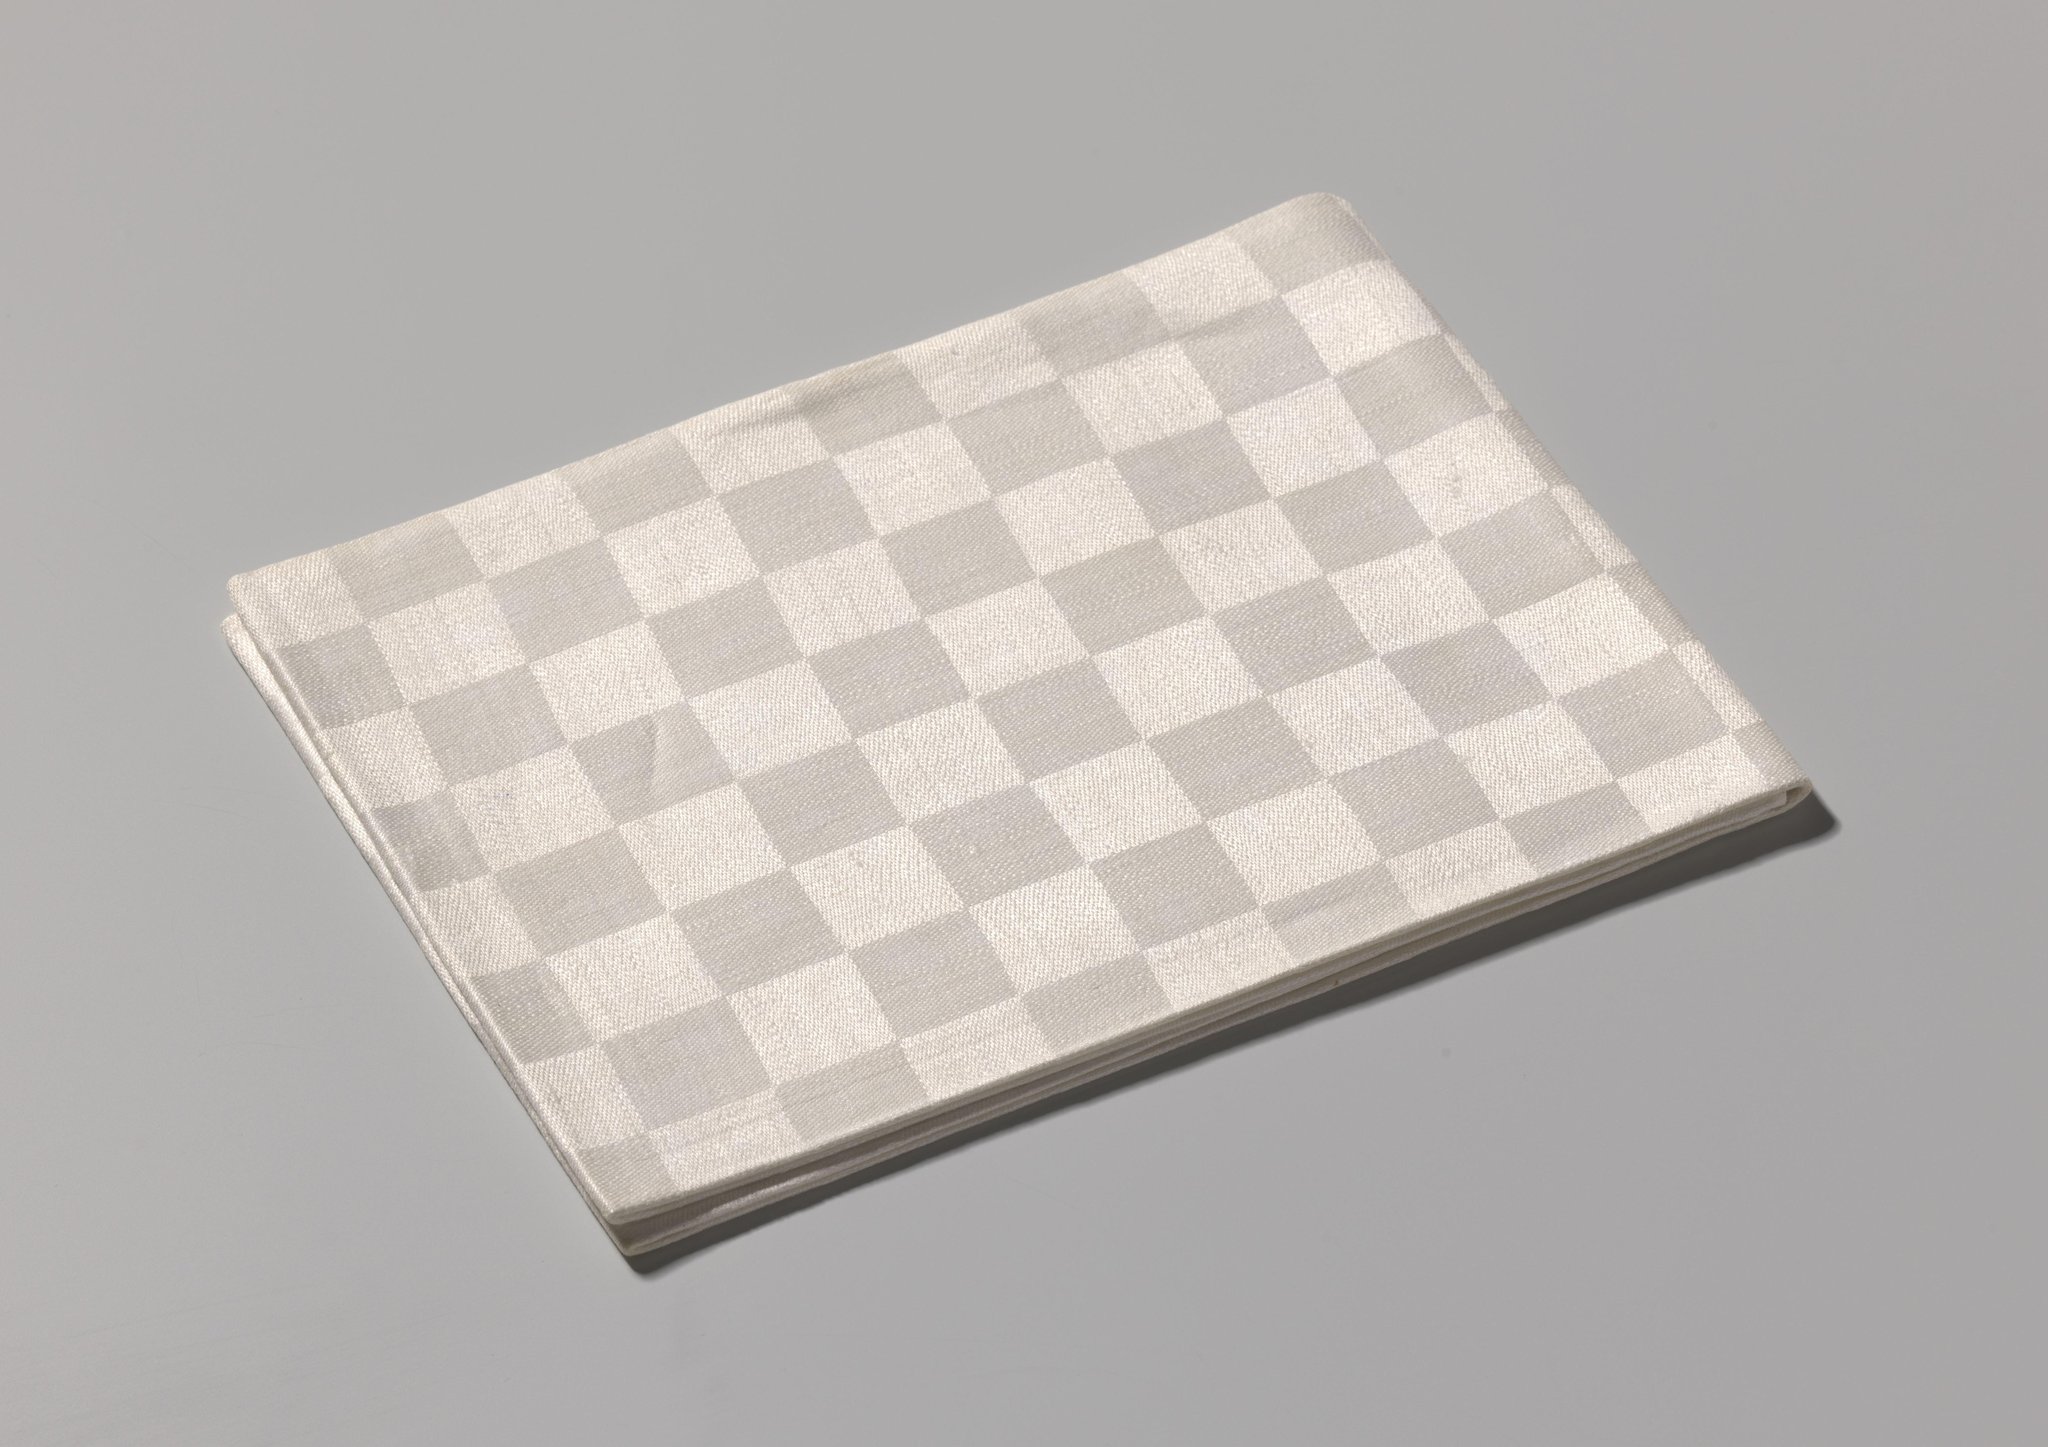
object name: napkin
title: Servet van linnen met pellenpatroon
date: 1725-1775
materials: linen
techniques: peeled fabric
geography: northern netherlands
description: wit linnen servet met pellen patroon, merk kroon IG